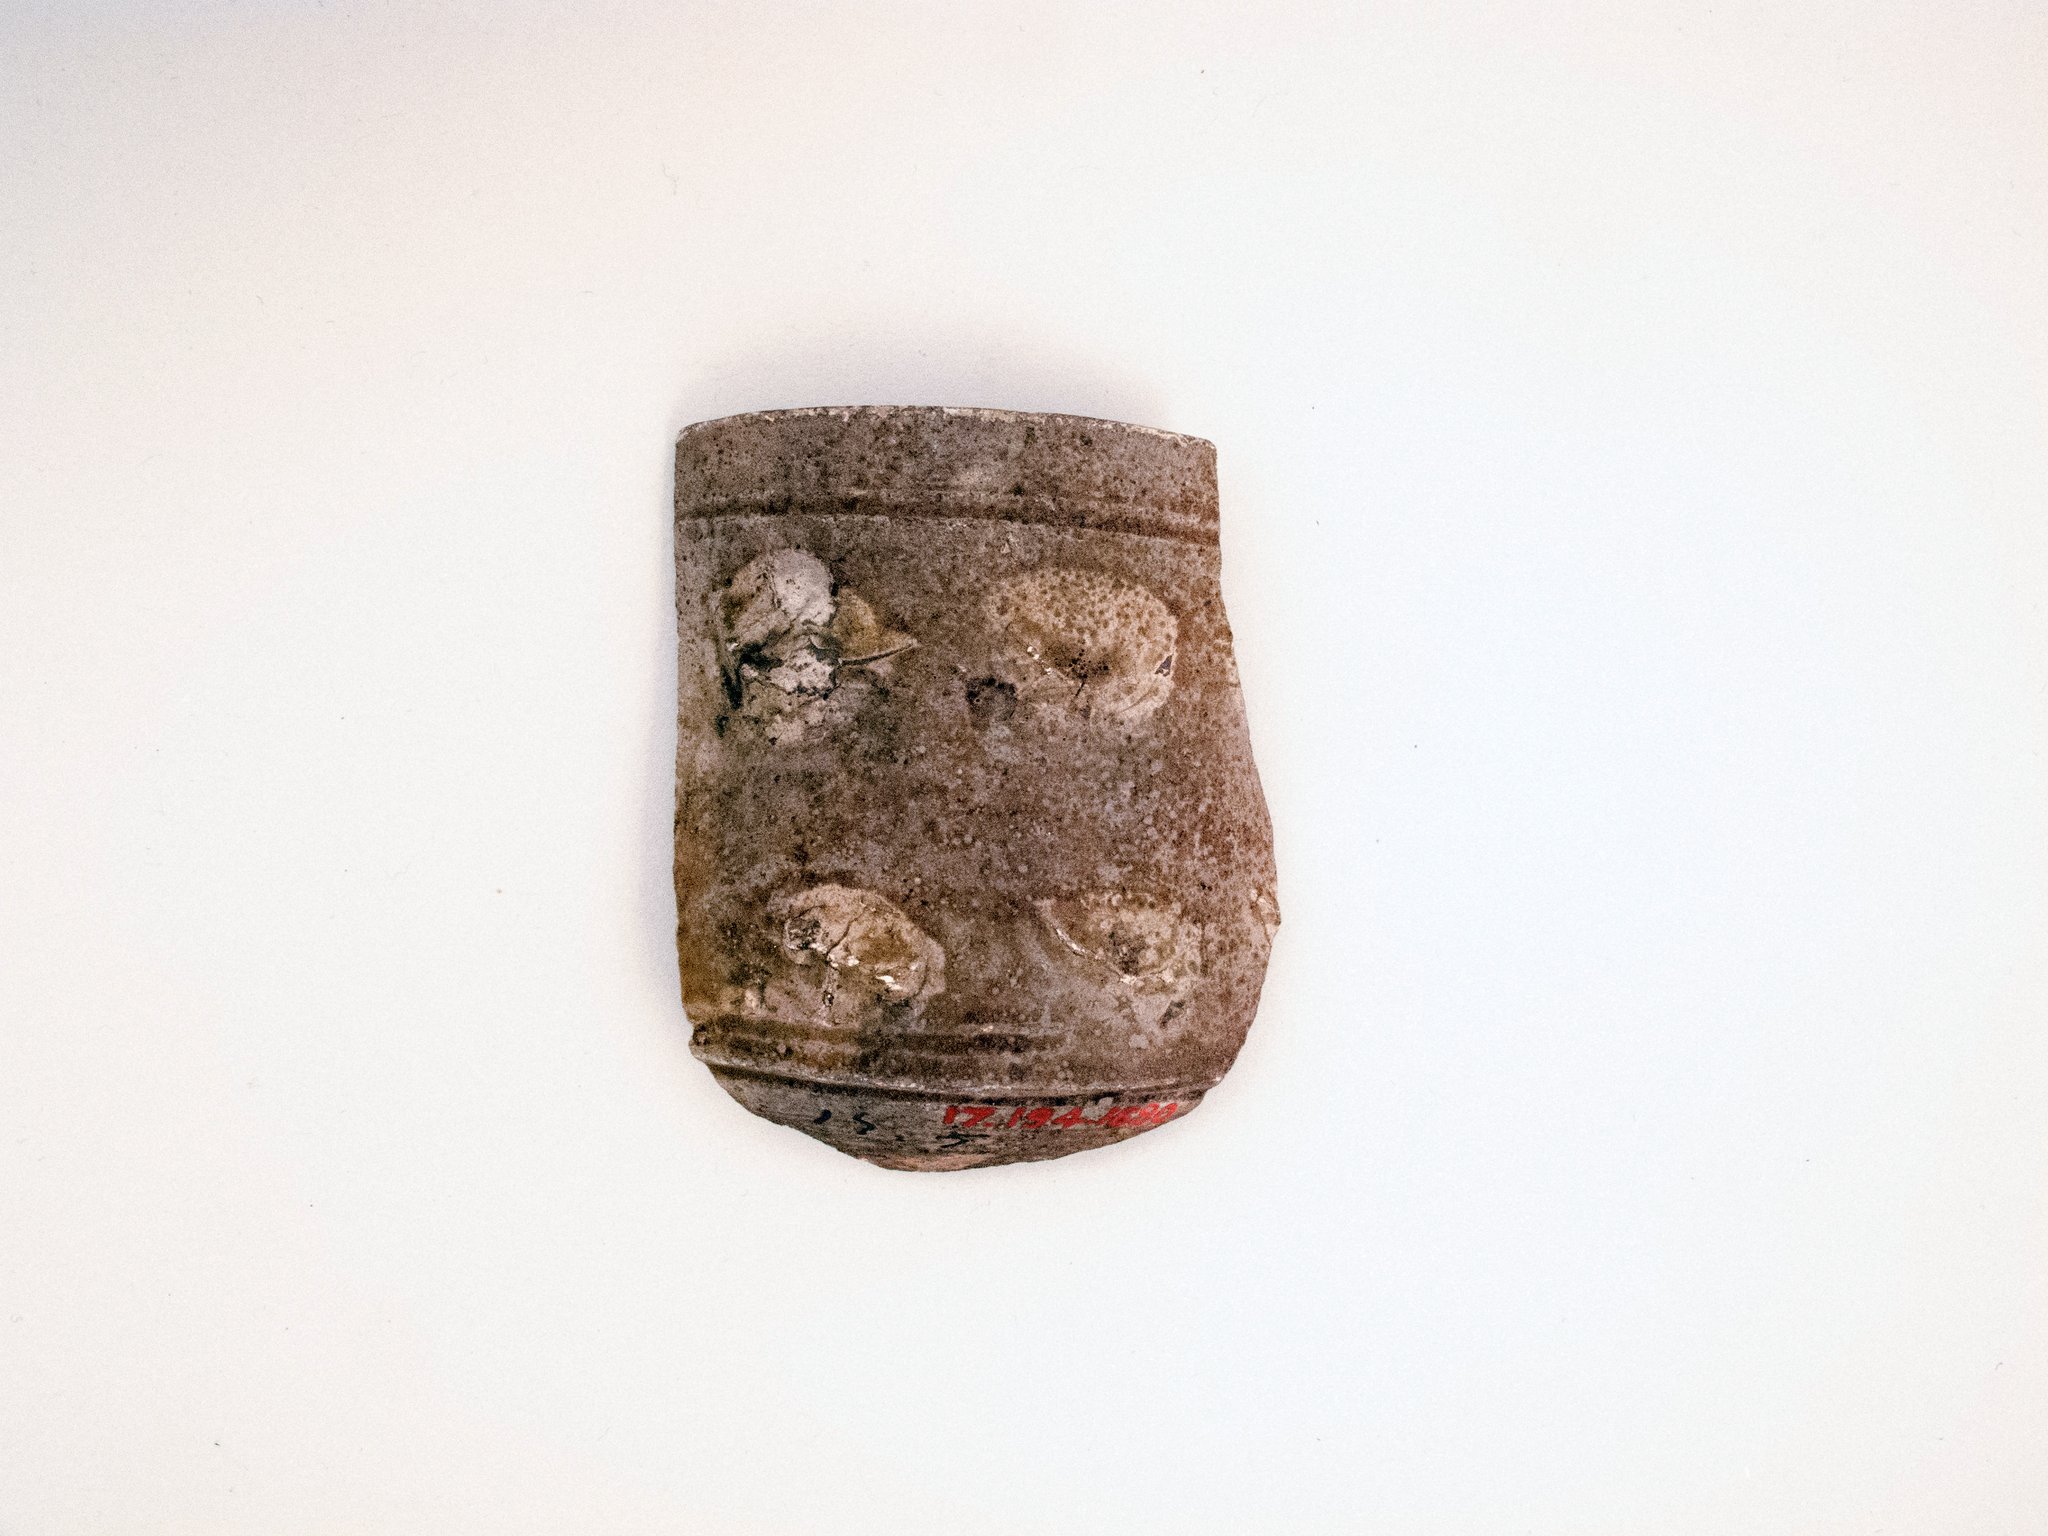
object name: vase fragment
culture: roman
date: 670 BCE-330 CE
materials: terracotta